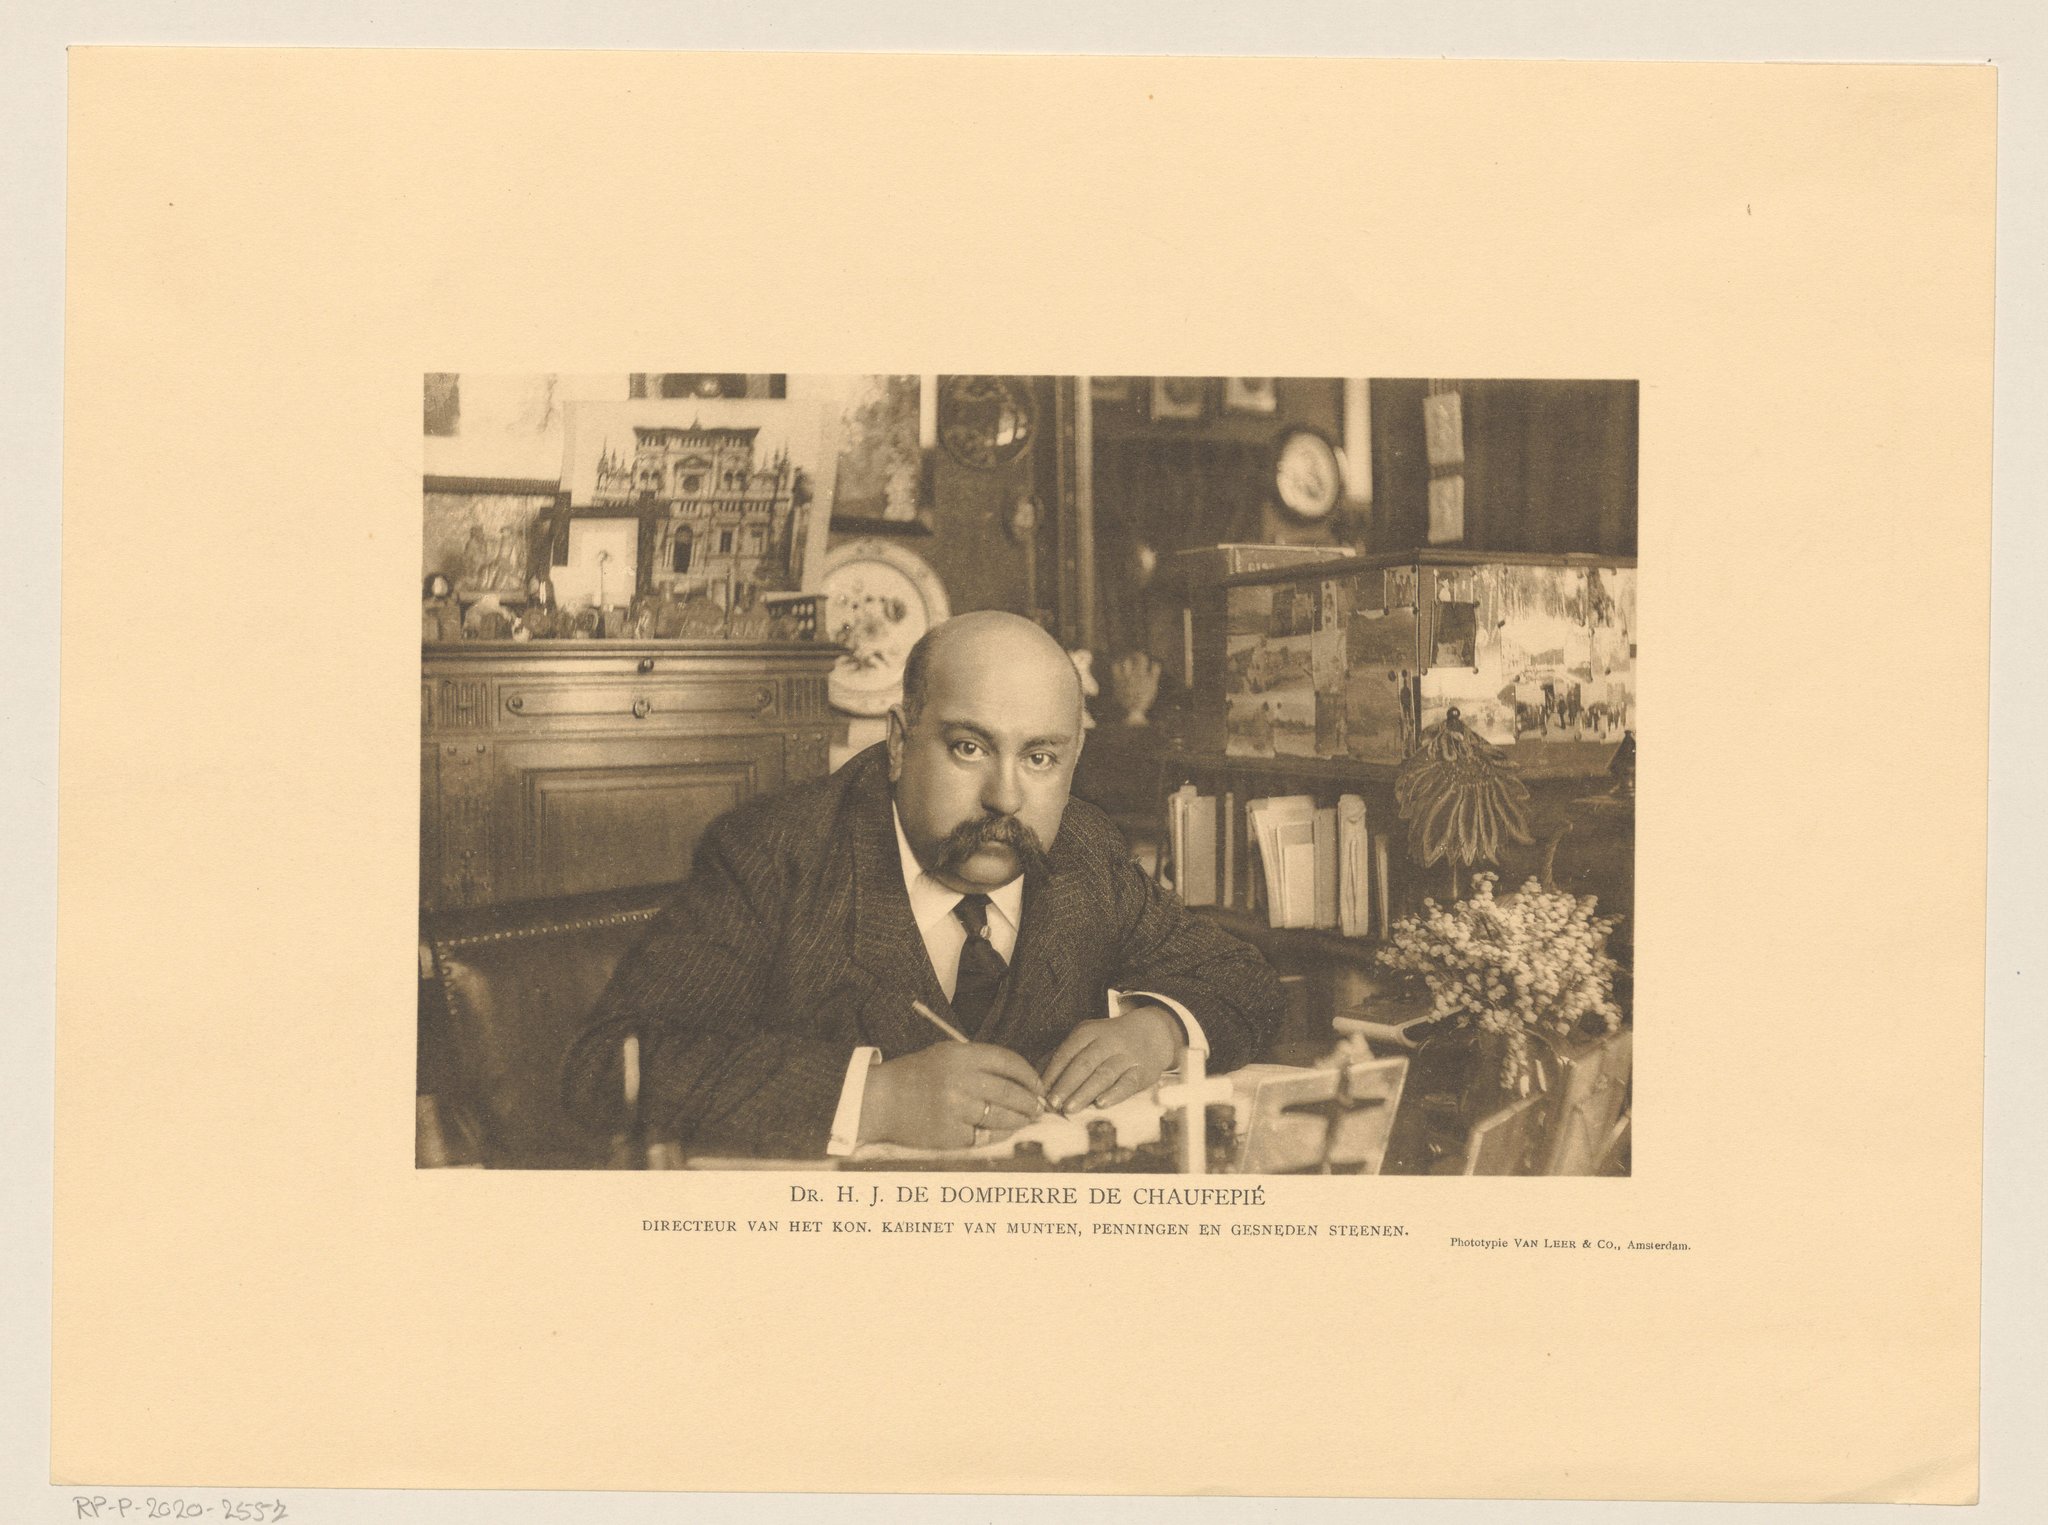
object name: photomechanical print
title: Portret van H.J. de Dompierre de Chaufepié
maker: Anonymous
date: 1880-1920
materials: paper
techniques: photograph, letterpress printing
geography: amsterdam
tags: amsterdam, historical persons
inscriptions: collector's mark: Lugt 2282